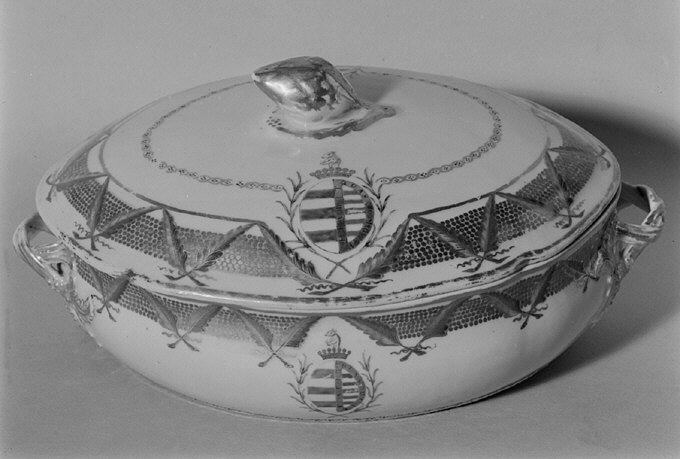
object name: vegetable dish with cover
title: Vegetable dish with cover (part of a service)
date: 1810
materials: hard paste porcelain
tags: coat of arms